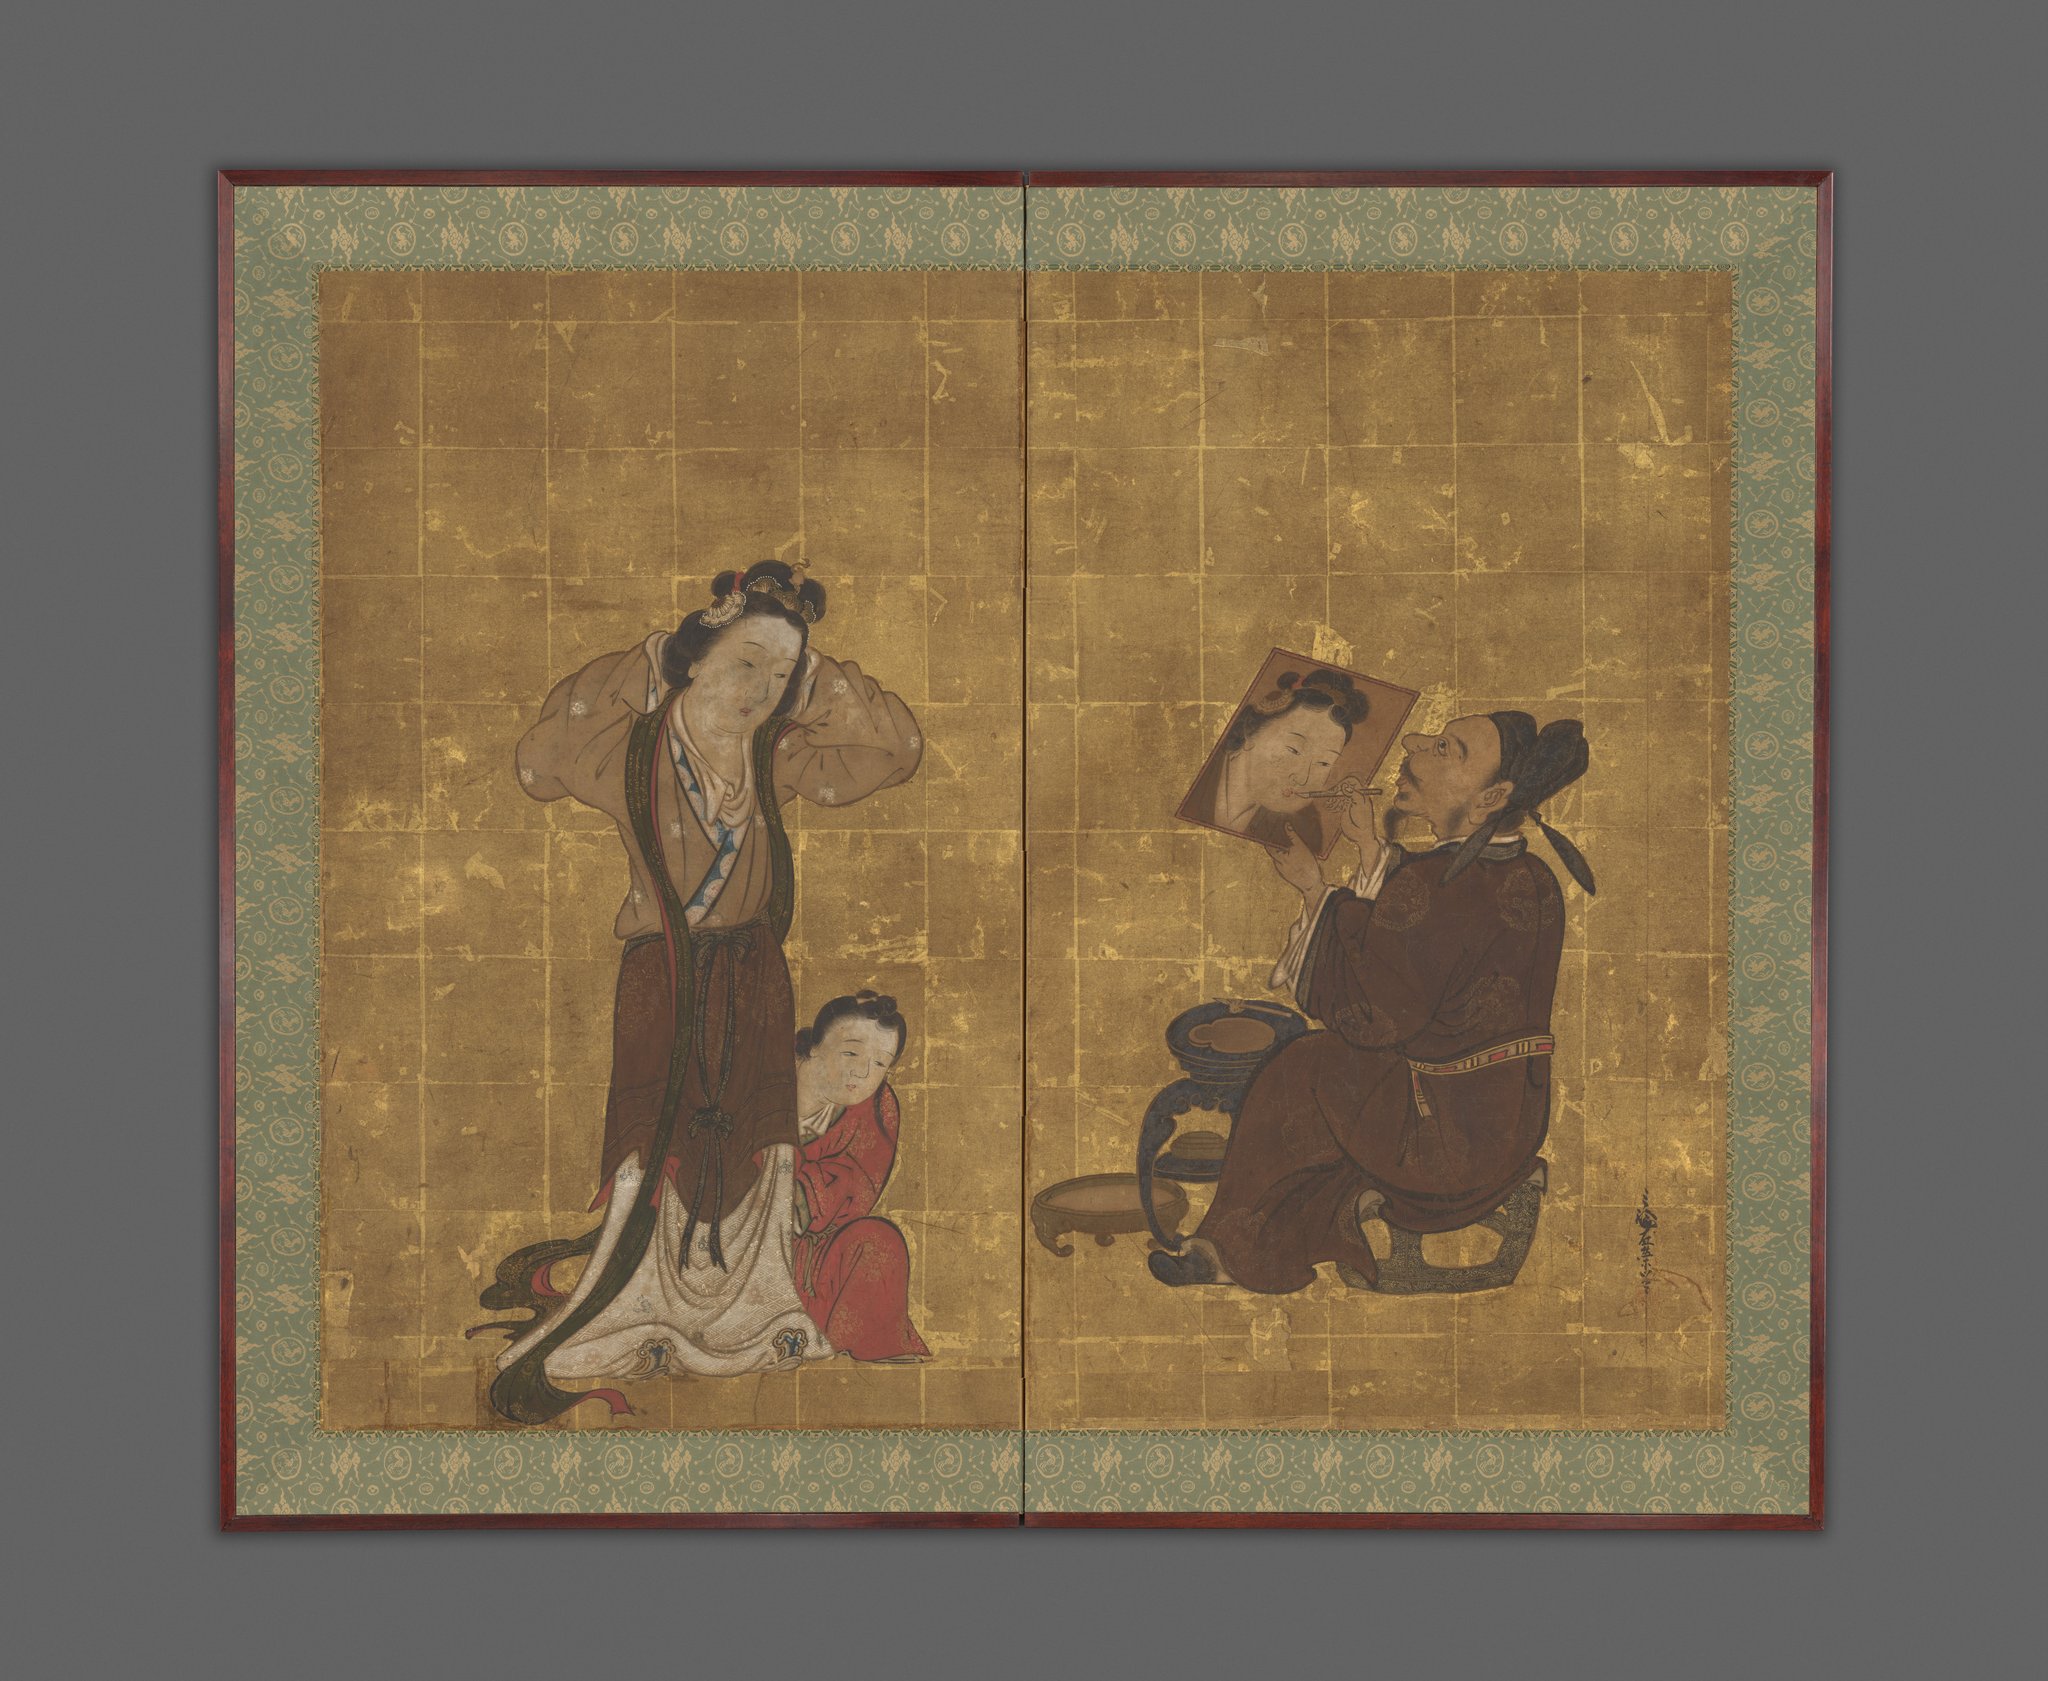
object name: screen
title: Chinese Portrait Painter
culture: japanese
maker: miwa zaiei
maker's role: artist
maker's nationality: japanese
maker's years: -1789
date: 1701-1800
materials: gold, ink, panel, paper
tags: painting,men,women,artists